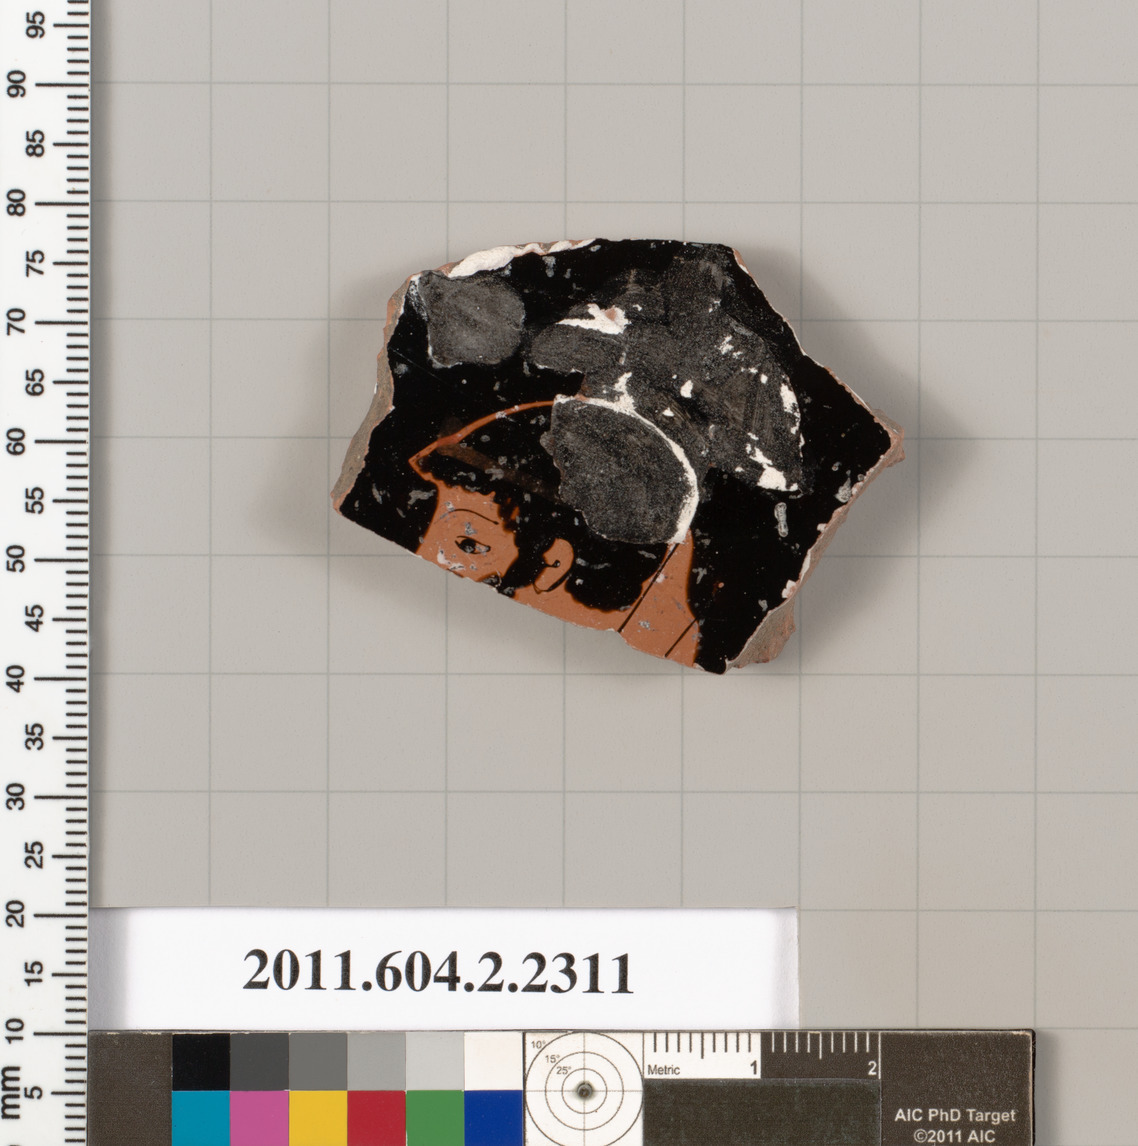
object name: pot fragment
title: Terracotta fragment of a pot; unglazed on the inside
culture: greek, attic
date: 475-451 BCE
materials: terracotta